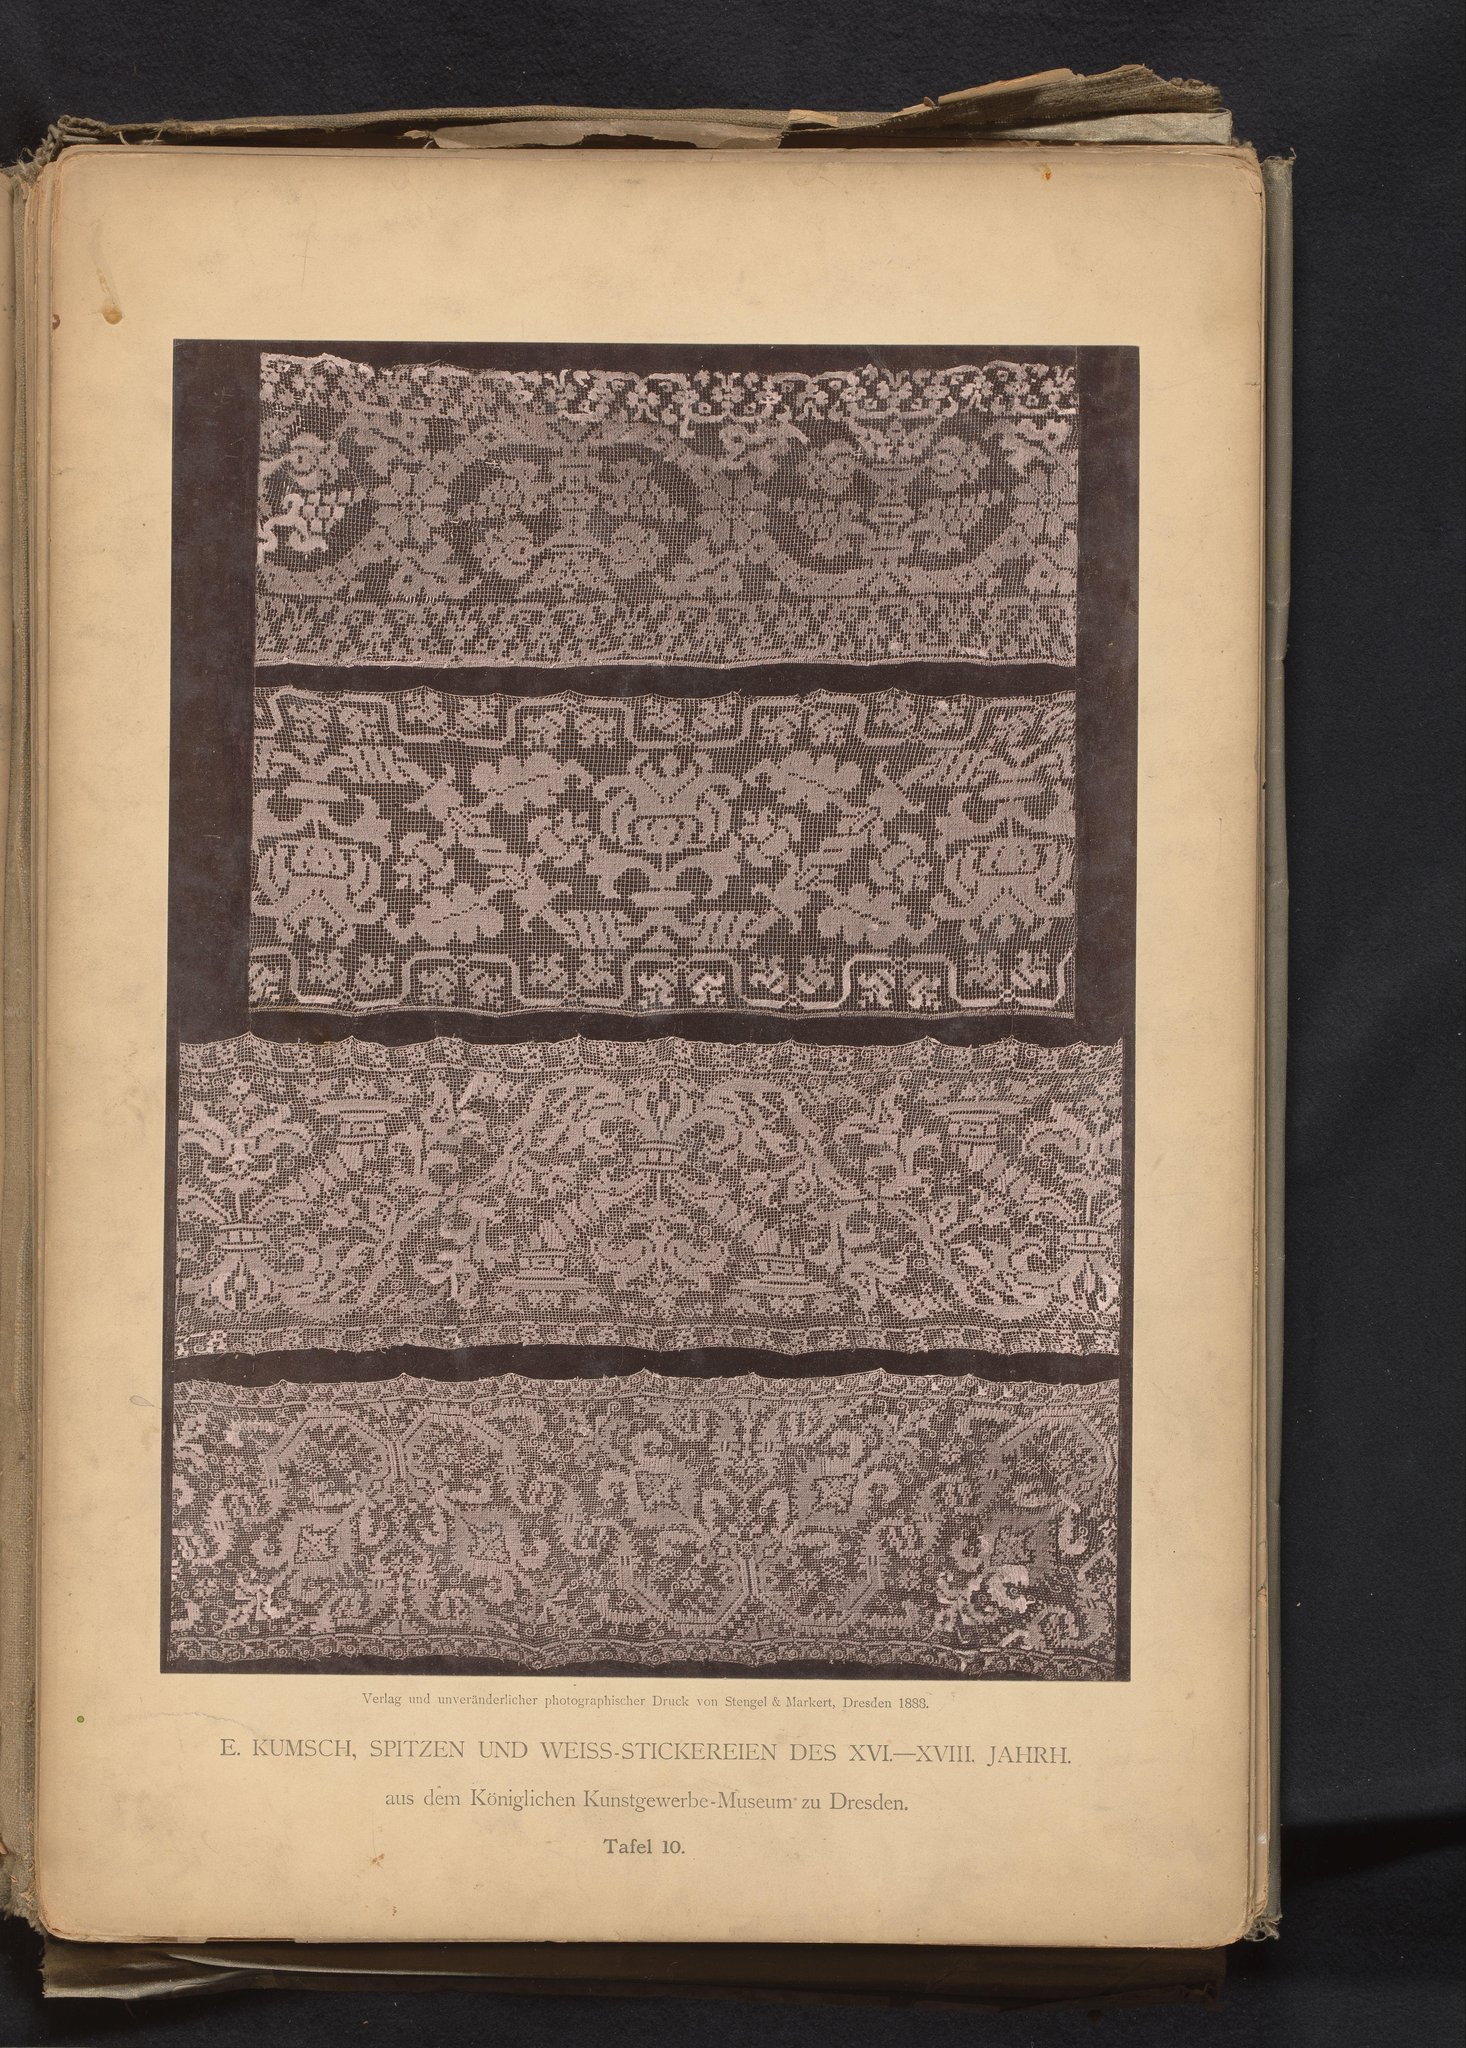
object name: photomechanical print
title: Twee stroken 16de-eeuws Duits kant en twee stroken 16de-eeuws Italiaans kant, uit de collectie van het Kunstgewerbemuseum in Dresden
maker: Anonymous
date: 1888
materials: paper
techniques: photograph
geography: dresden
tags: lace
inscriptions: number: ‘Tafel 10.’, inscription: ‘E. KUMSCH, SPITZEN UND WEISS-STICKEREIEN DES XVI.-XVIII. JAHRH./ aus dem Königlichen Kunstgewerbe-Museum zu Dresden’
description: Deze prent maakt deel uit van een omslag met 49 prenten en een lijst van afbeeldingen.